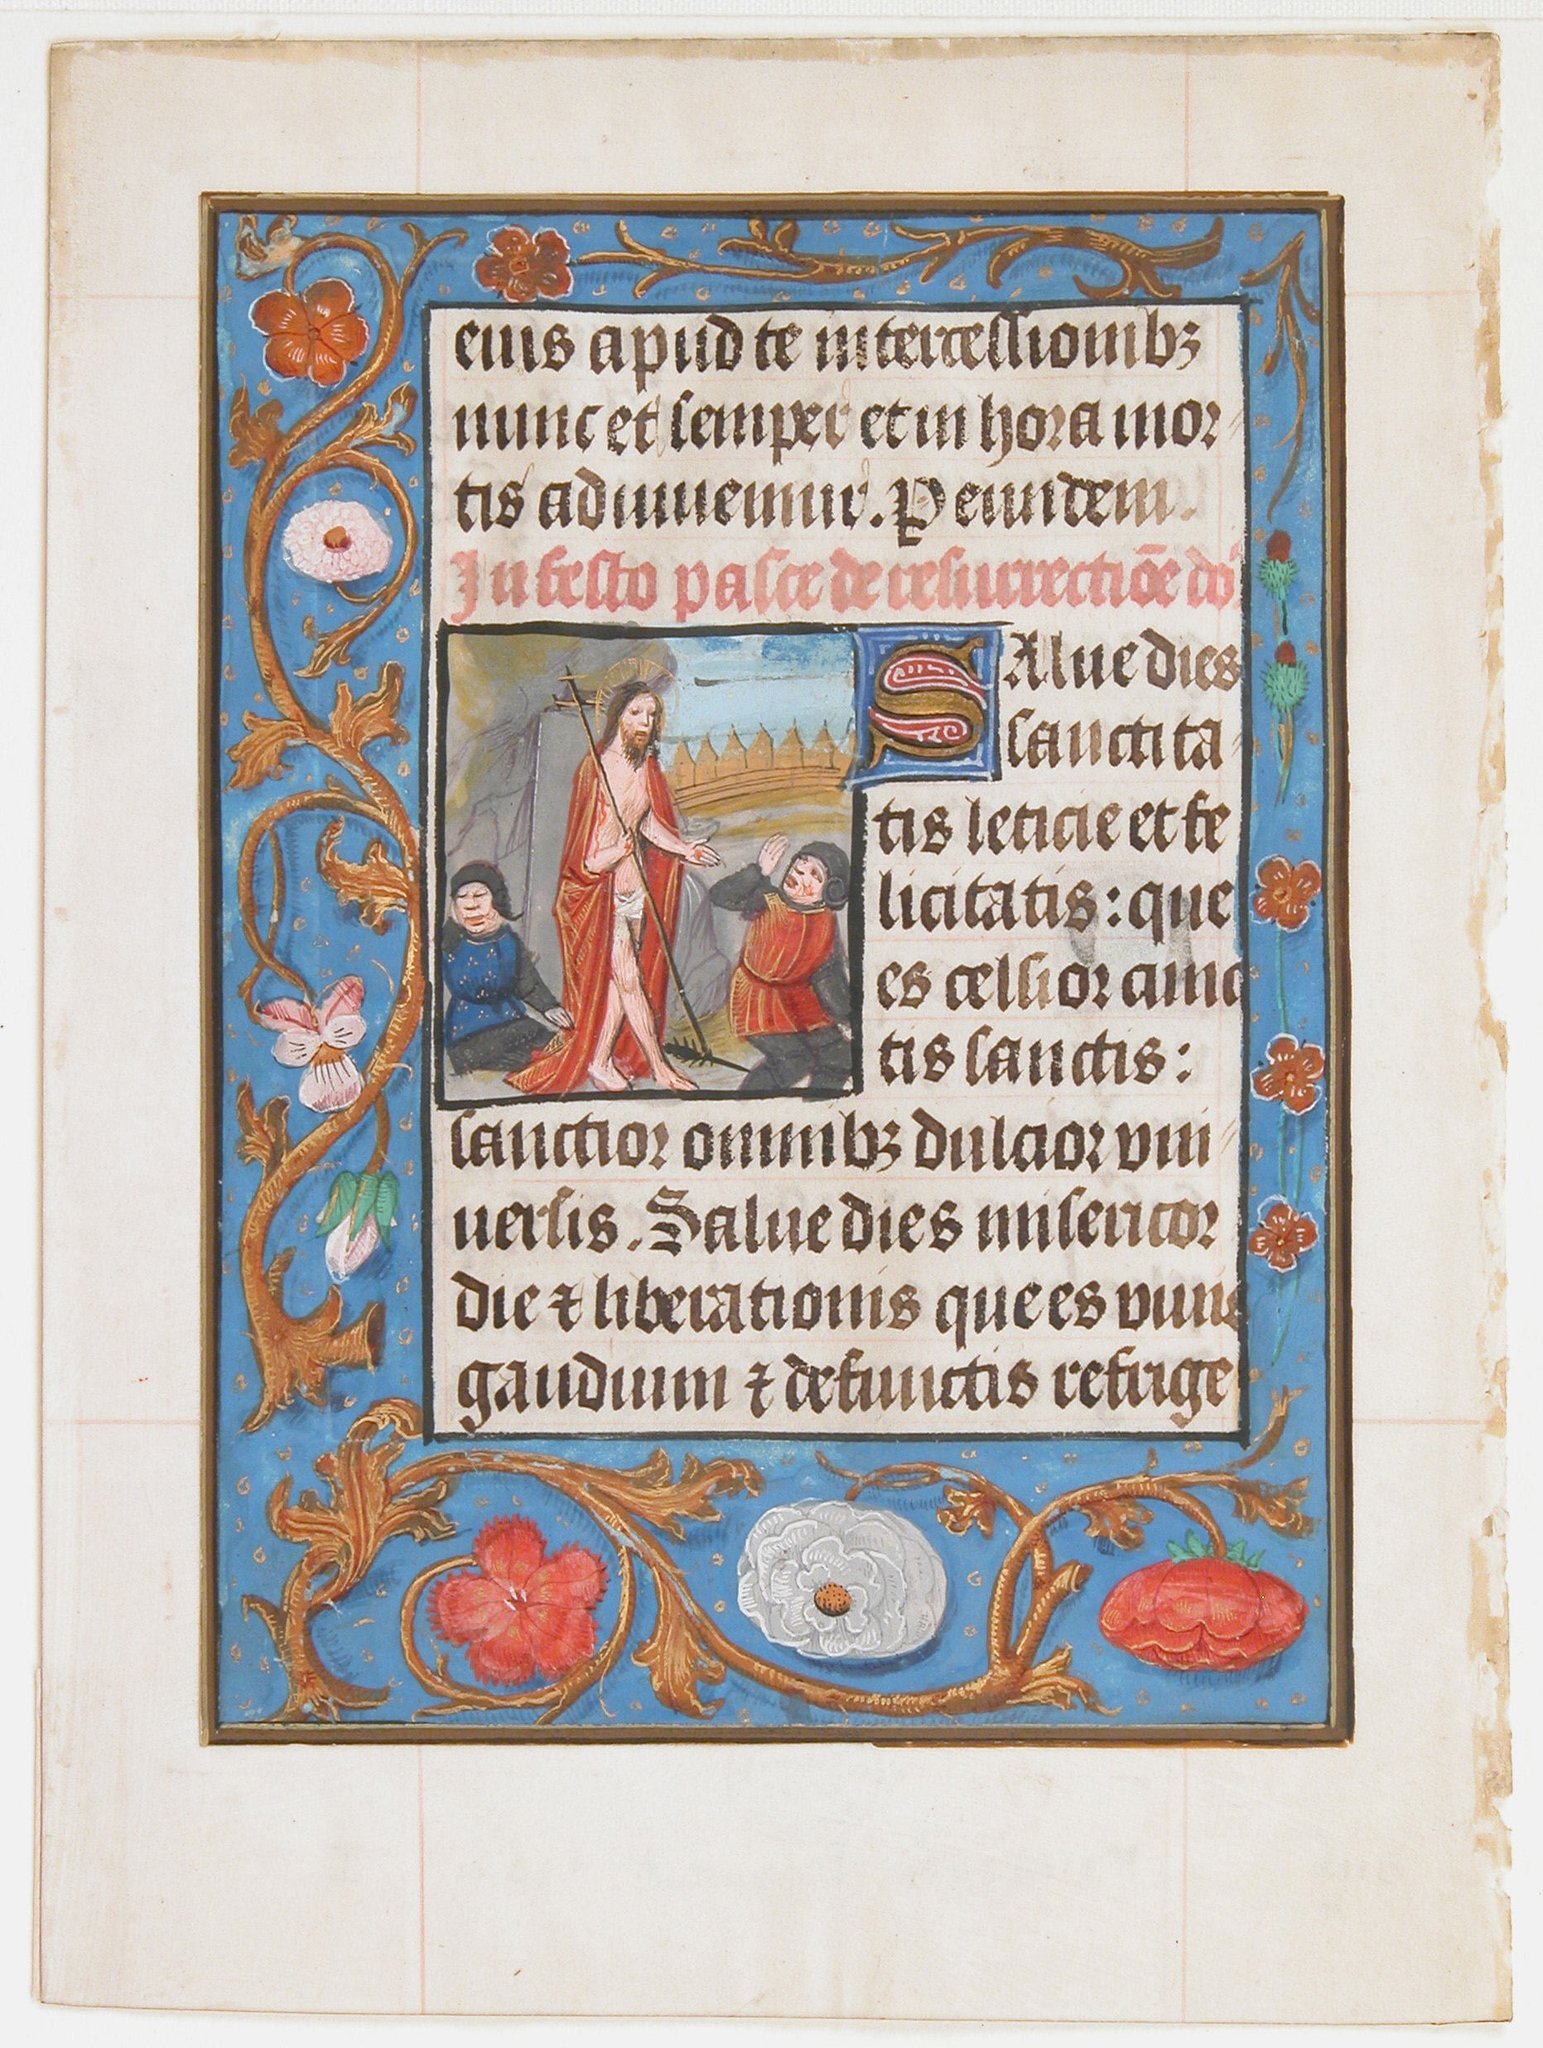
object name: book of hour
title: Manuscript Leaf with the Resurrection, from a Book of Hours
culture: dutch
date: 1500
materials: gold, ink, parchment, paint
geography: netherlands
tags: christ